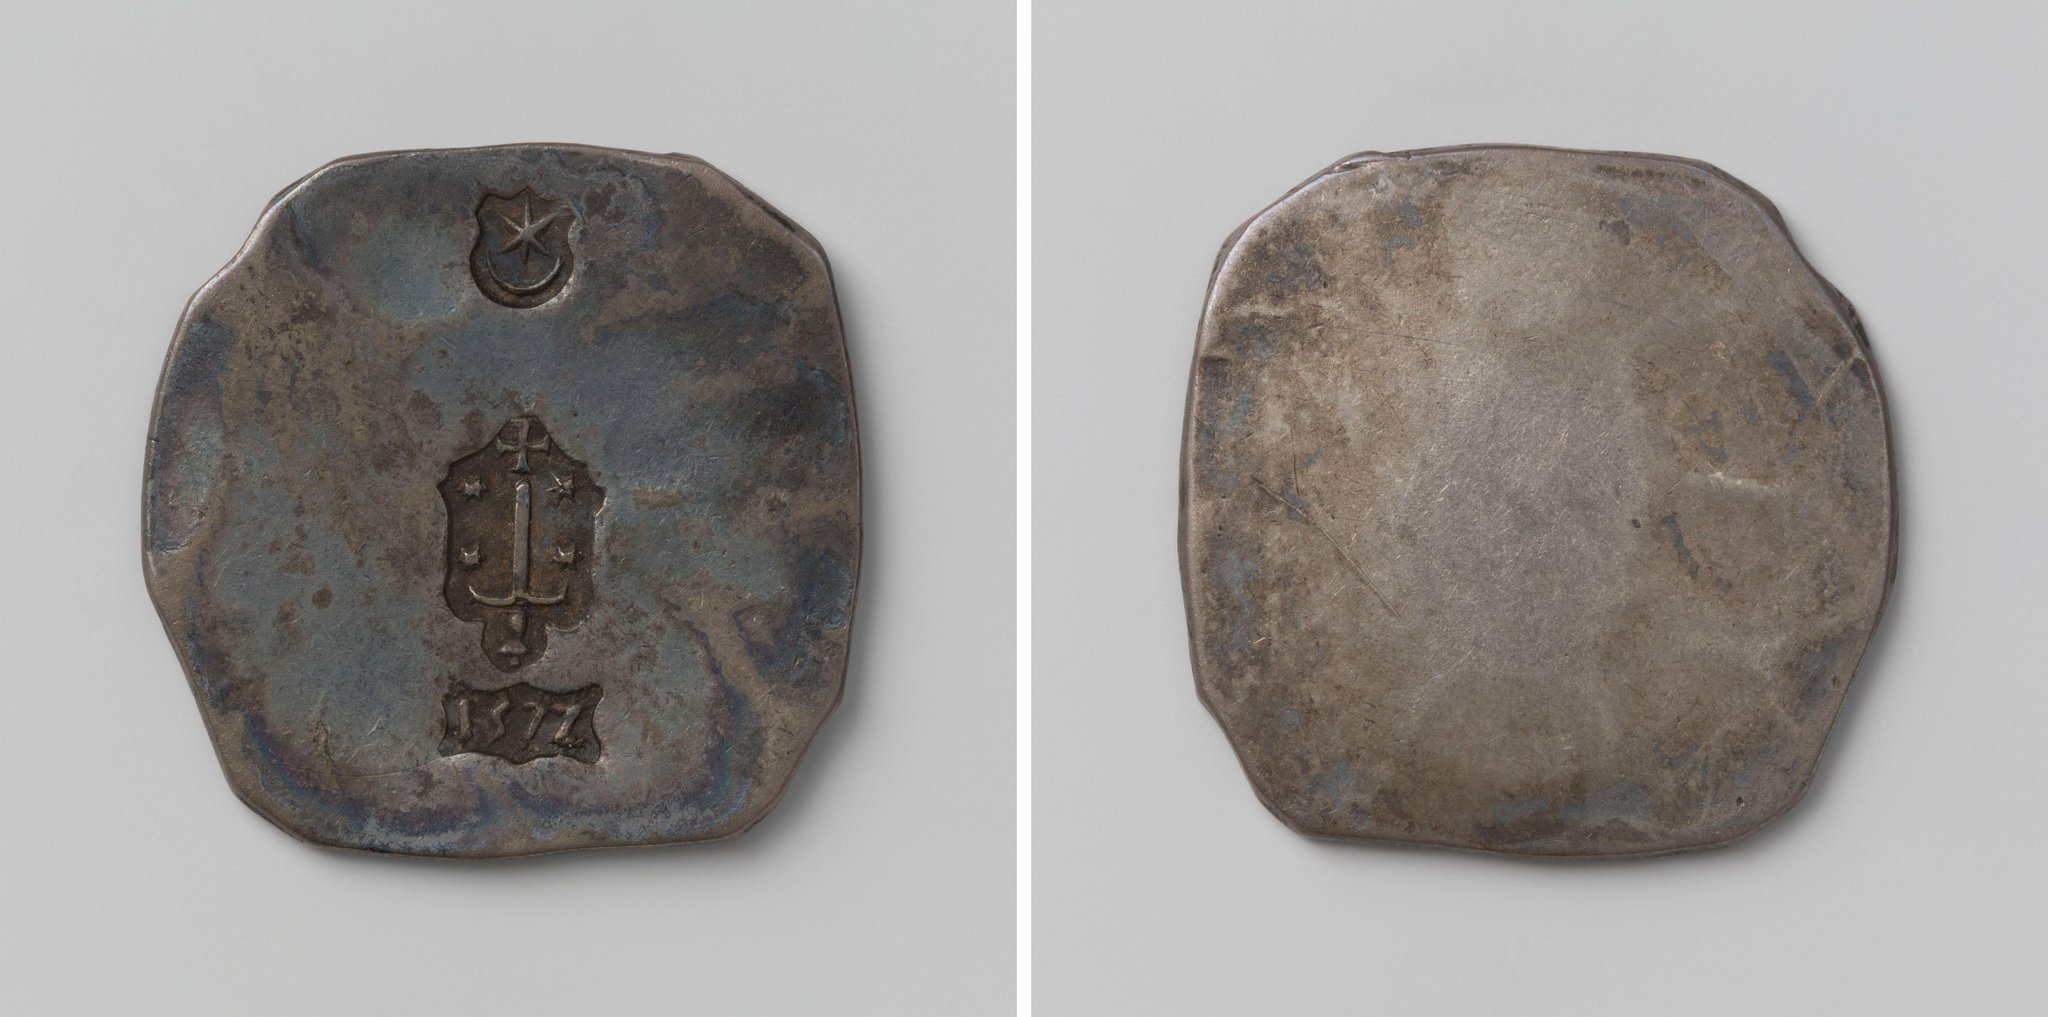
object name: siege coin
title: Halve daalder, noodmunt uit Haarlem, geslagen tijdens het beleg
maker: Anonymous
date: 1572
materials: silver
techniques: striking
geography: haarlem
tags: haarlem